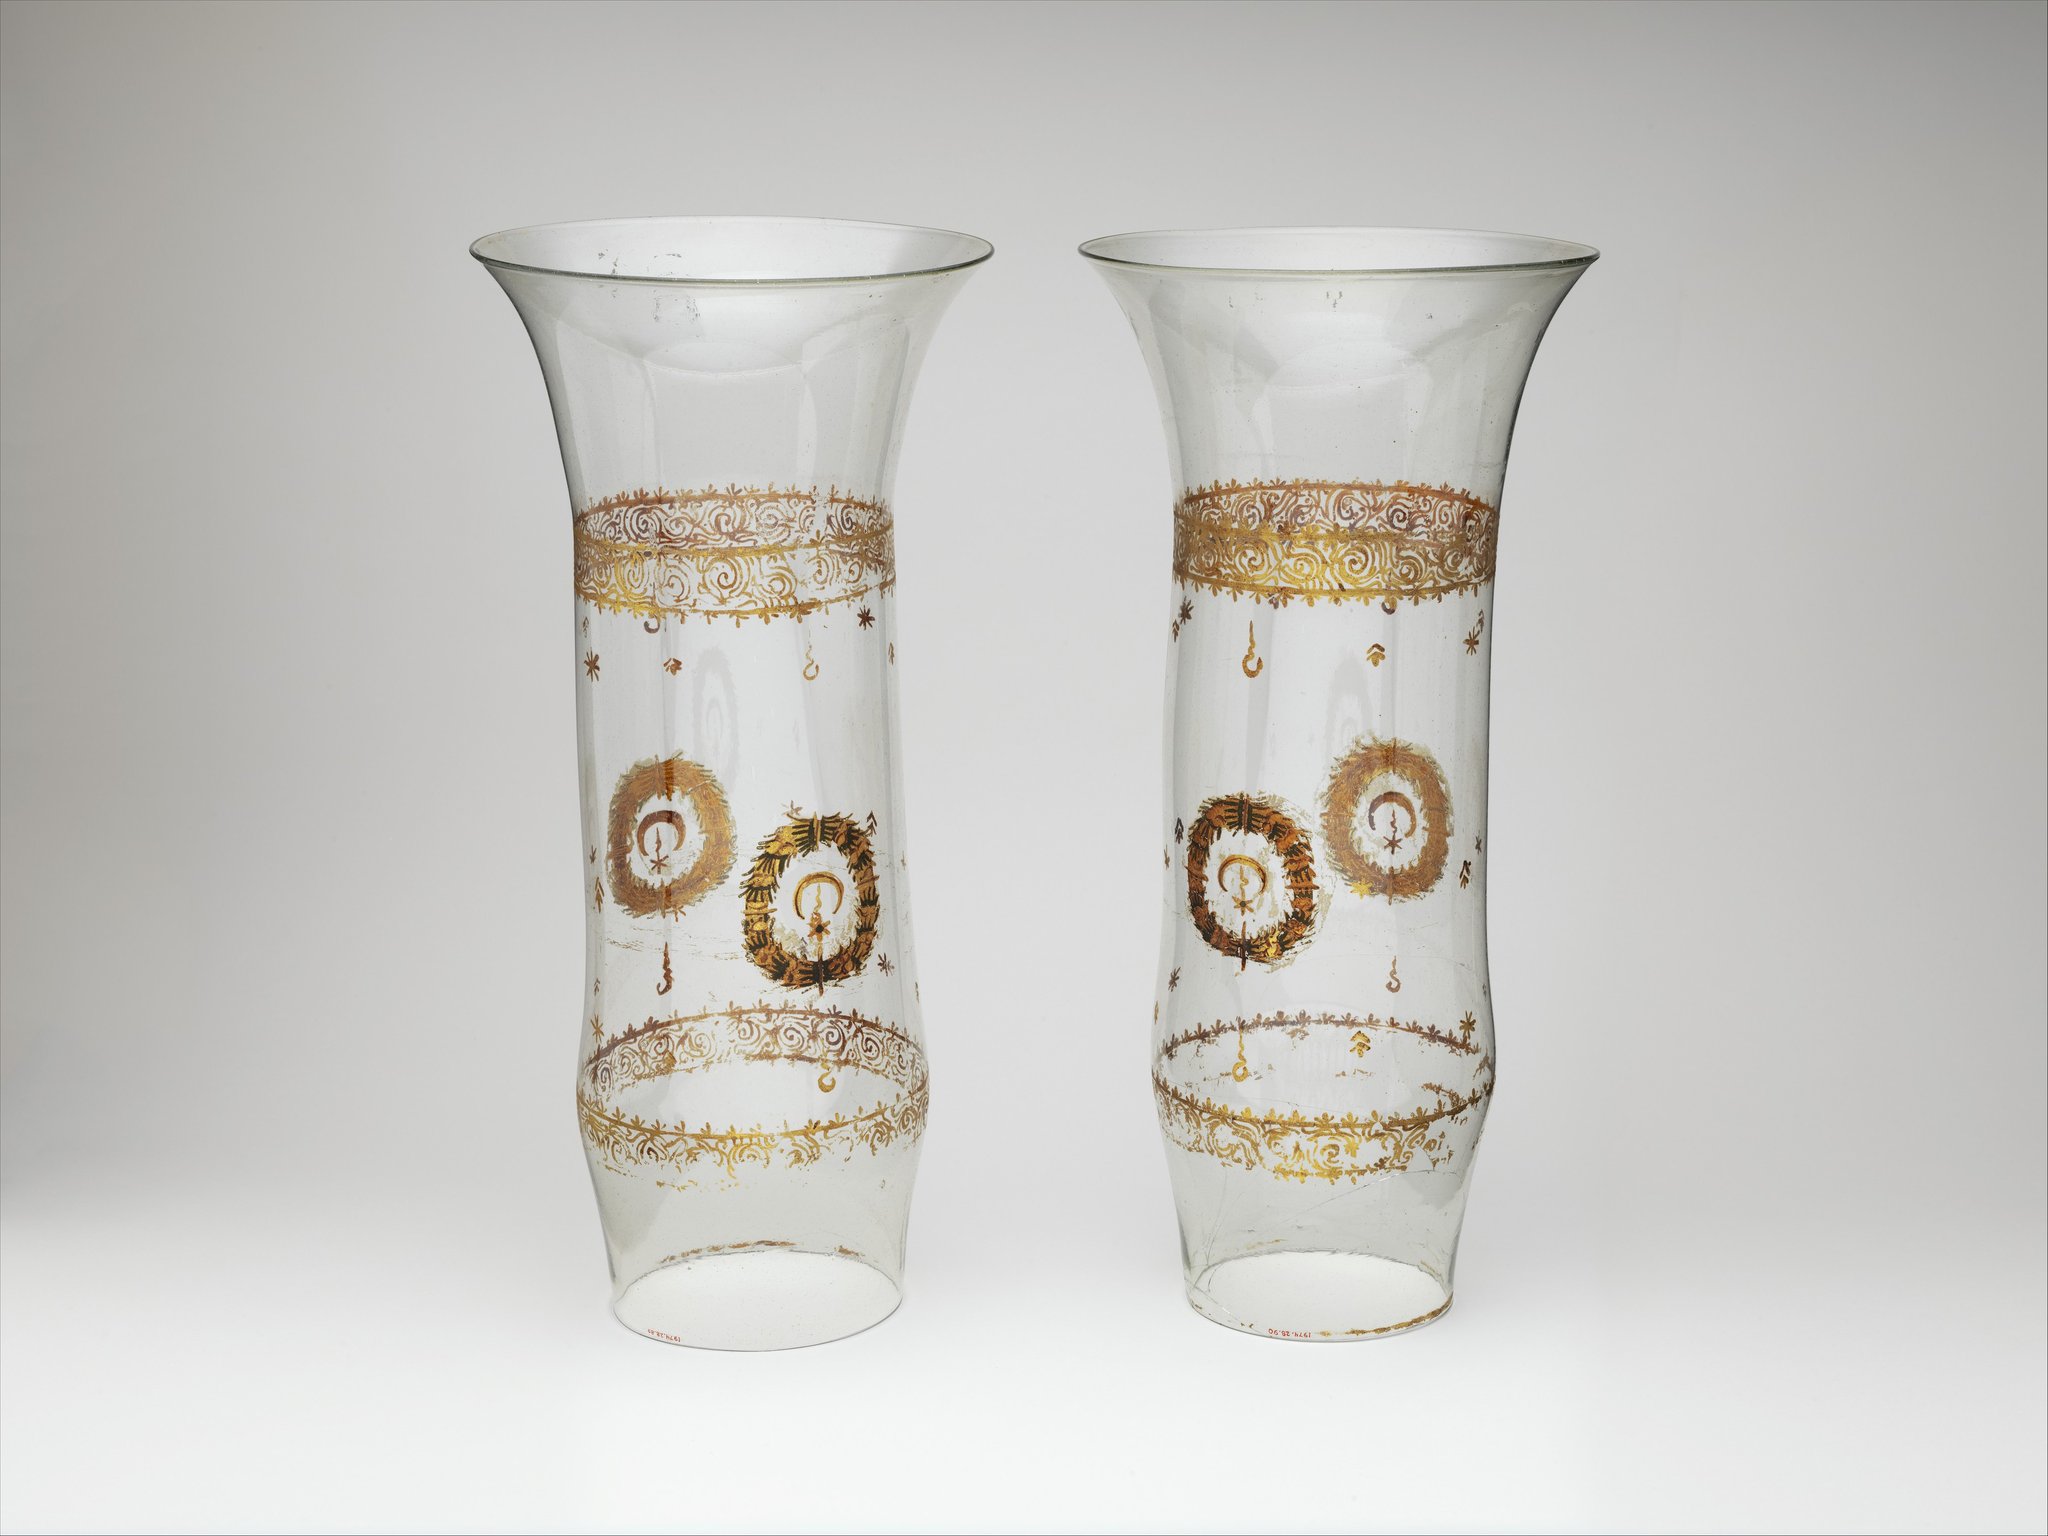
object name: storm shade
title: Storm shade (one of a pair)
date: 1560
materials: glass